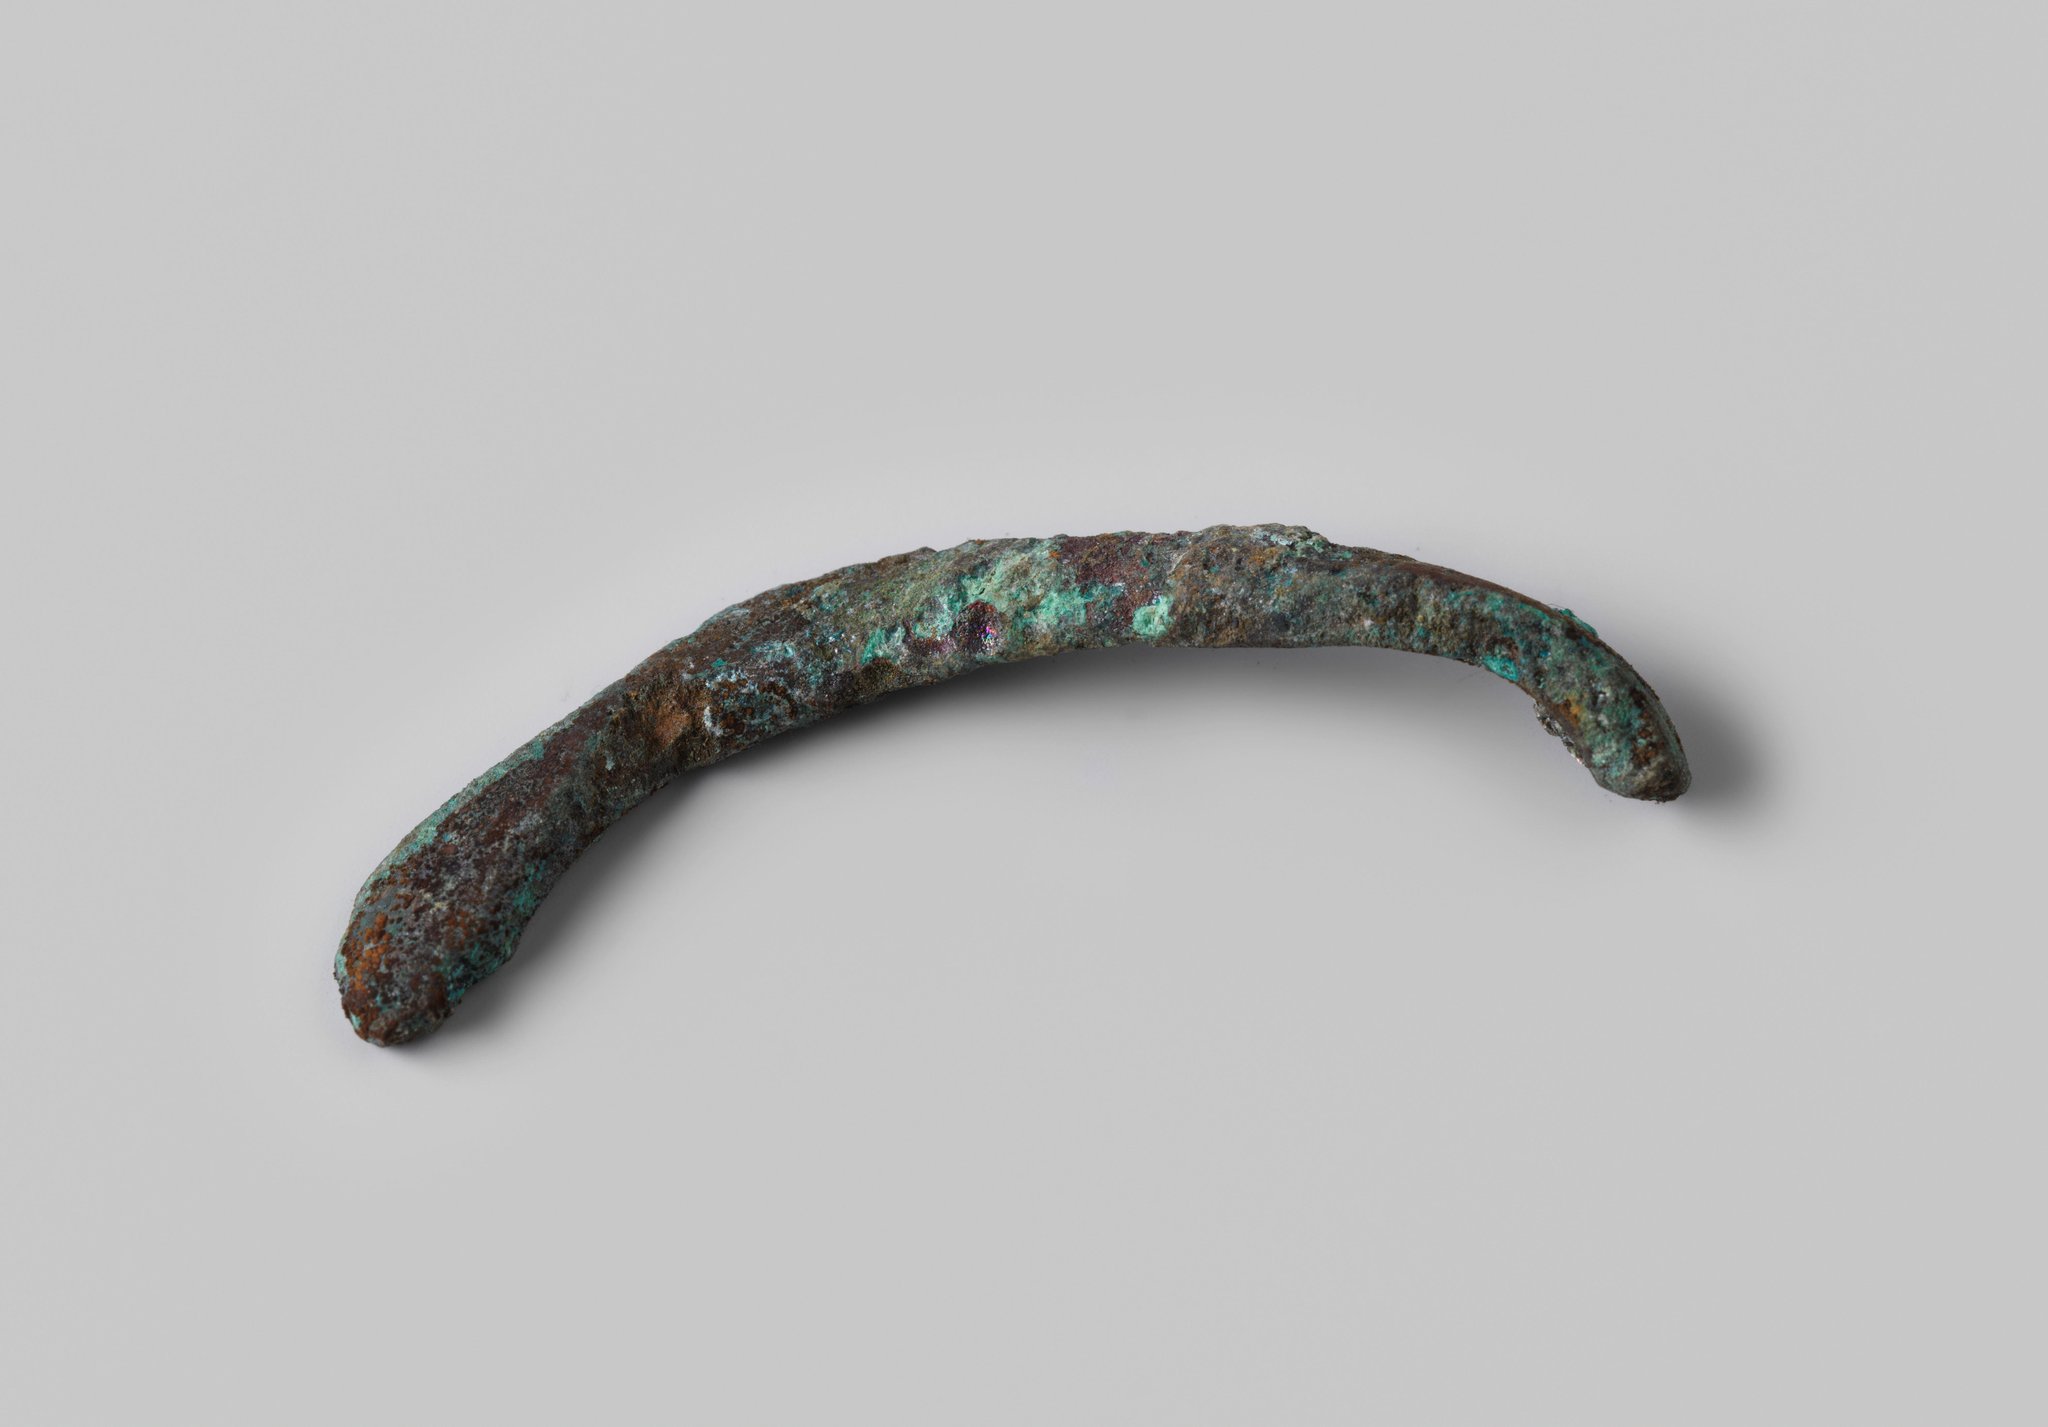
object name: fragment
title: Fragment van koper uit het wrak van de Oost-Indiëvaarder Hollandia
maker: Anonymous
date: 1700-1743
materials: copper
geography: netherlands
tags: verenigde oostindische compagnie, hollandia (schip), annet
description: Varied parts or fragments, strips and strip-shaped fragments; fragm.